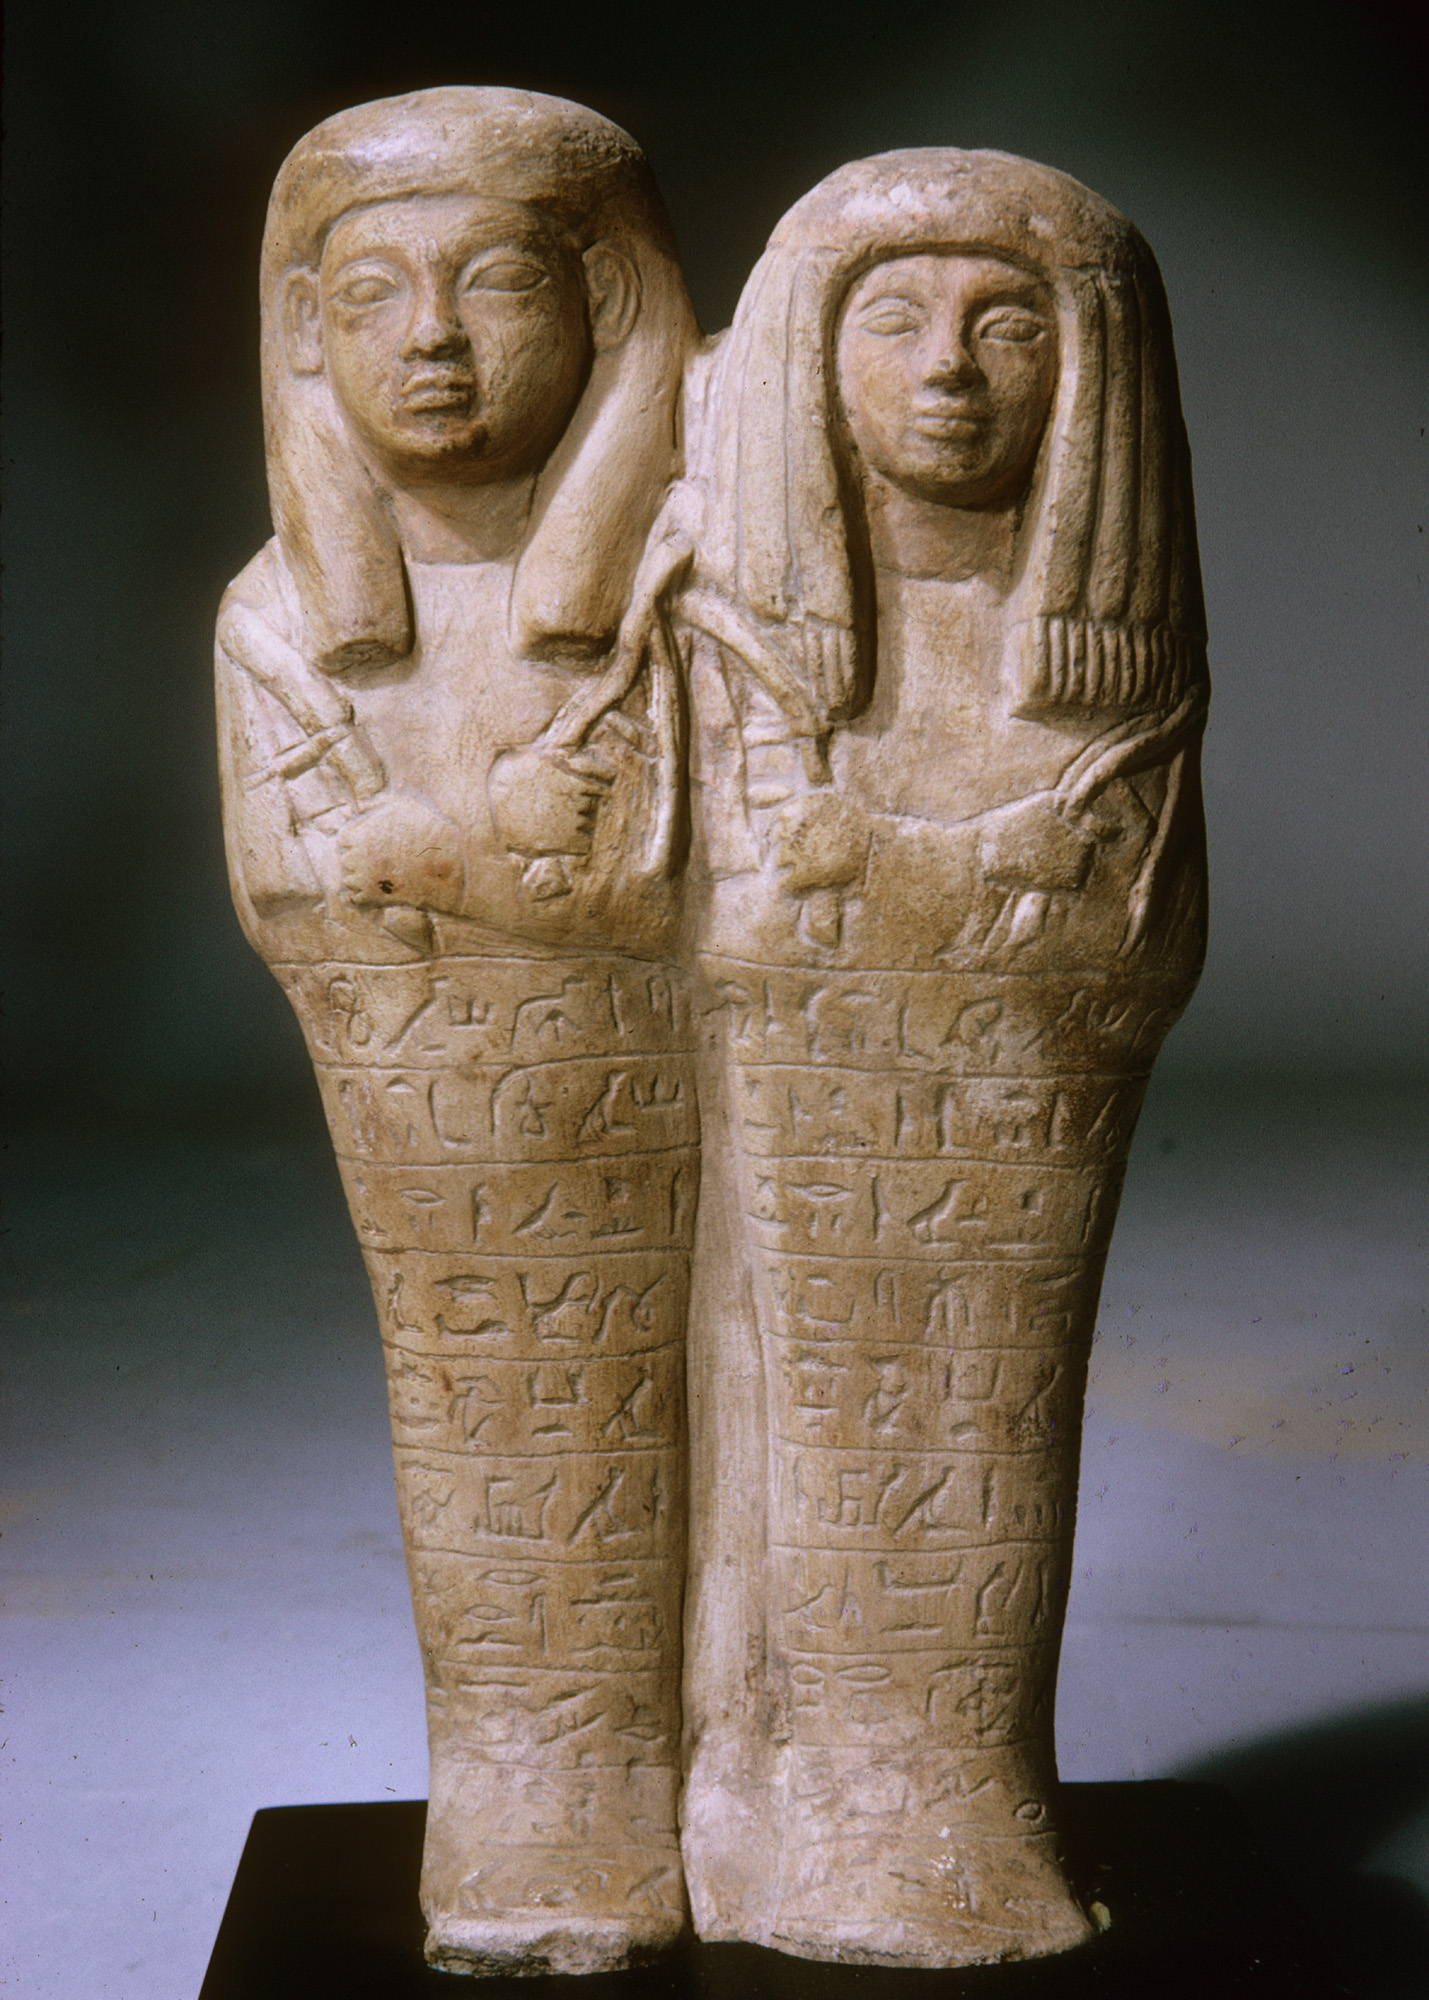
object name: shabti, double, khaemwaset, mesyt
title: Double Shabti of Khaemwaset and Mesyt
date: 1336-1213 BCE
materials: limestone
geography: egypt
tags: hieroglyphs